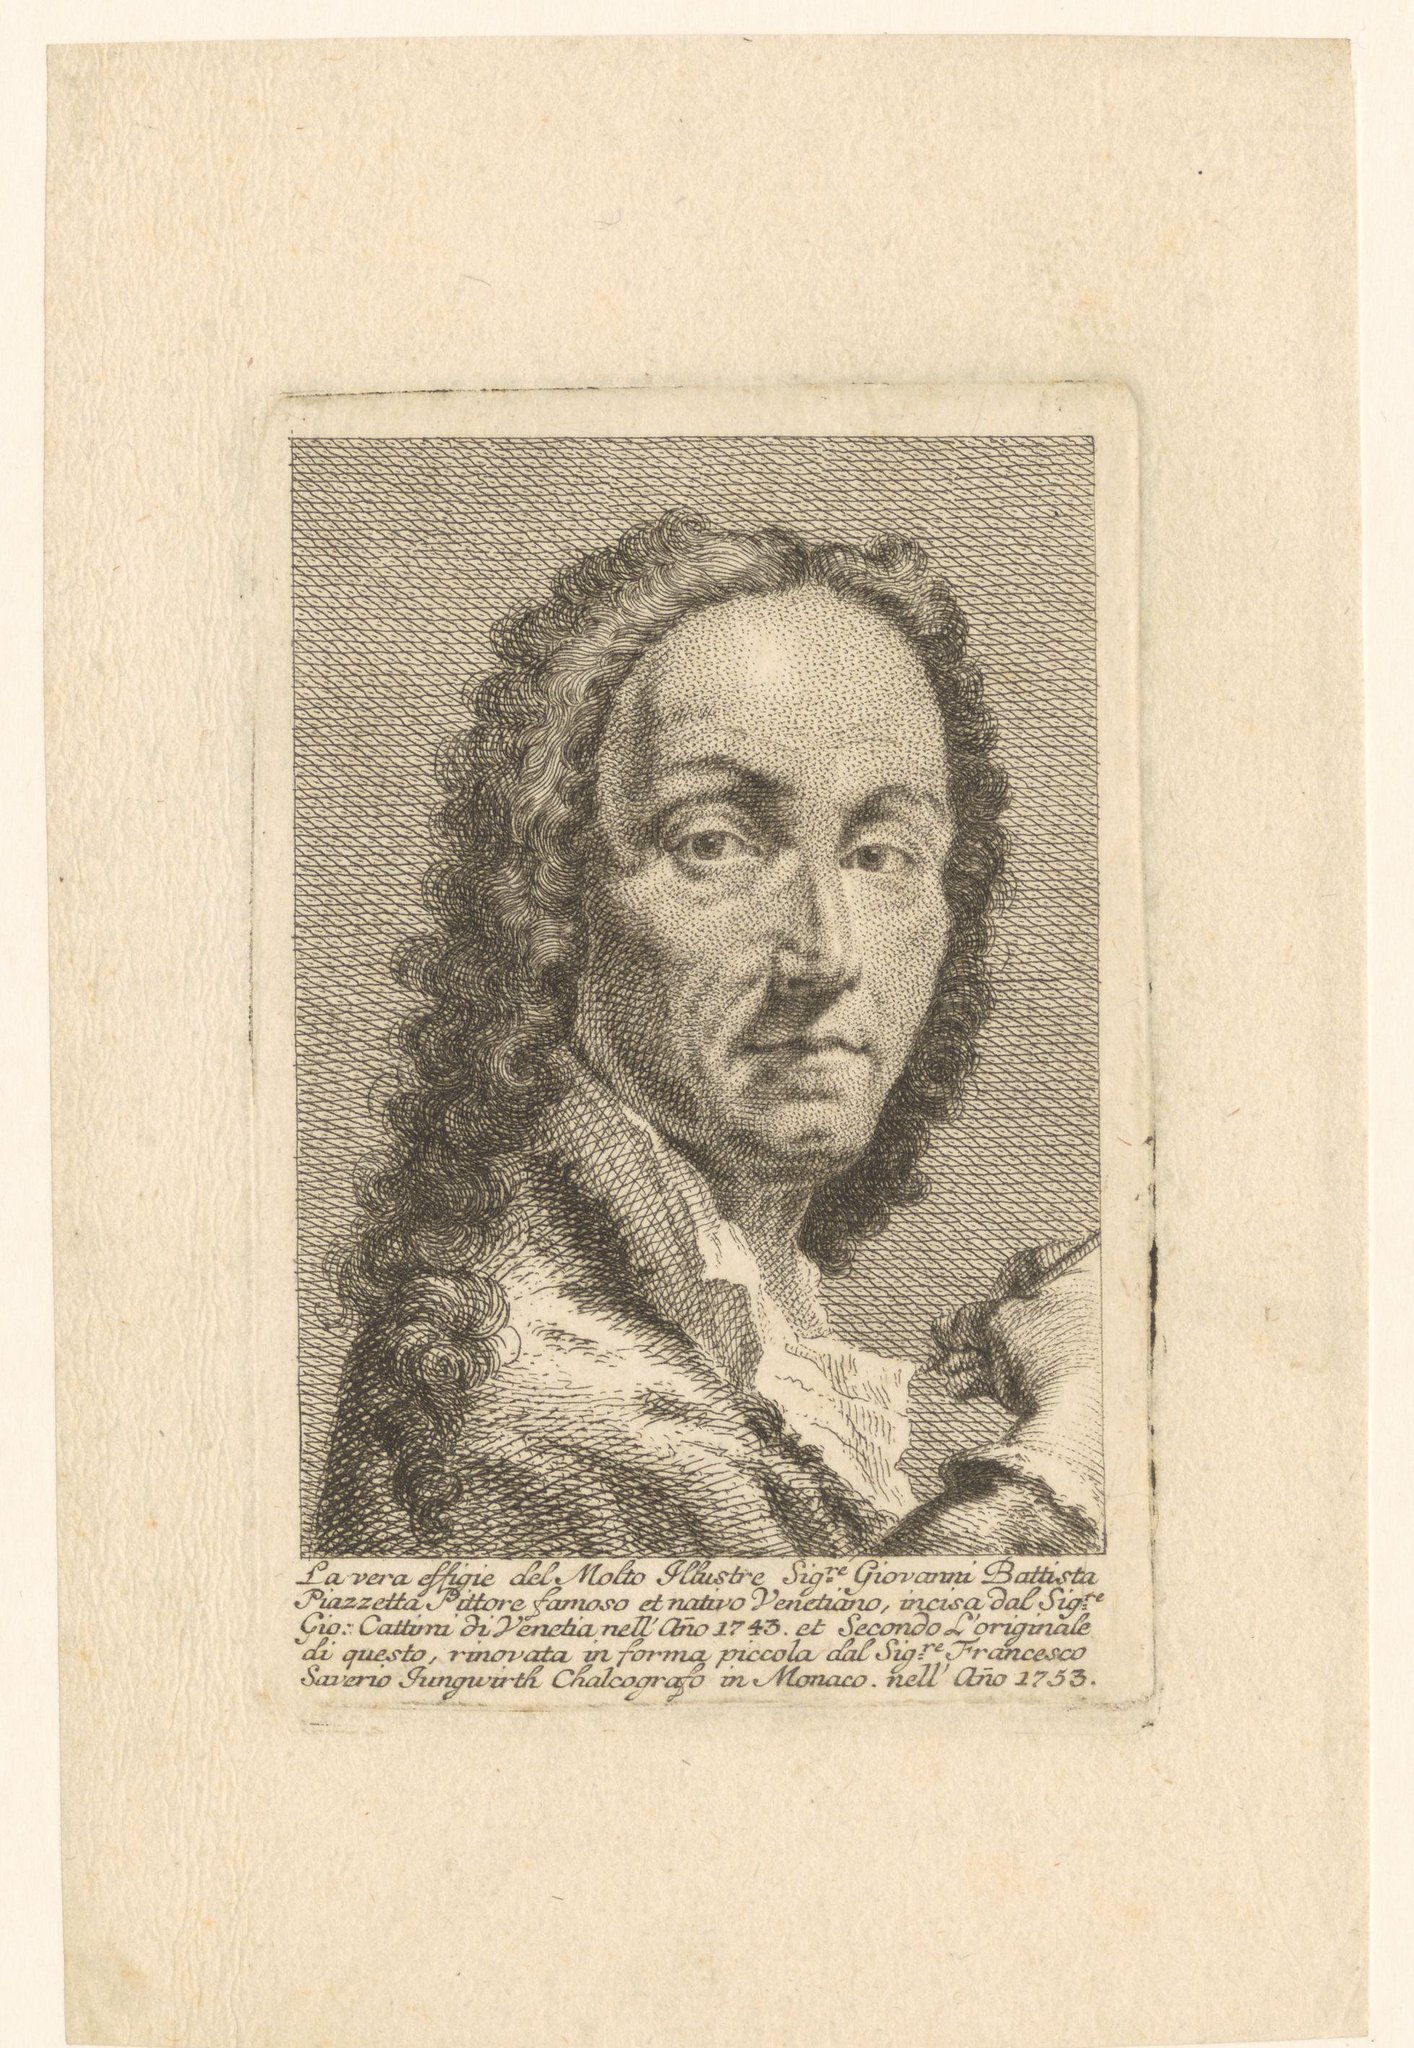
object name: print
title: Portret van Giovanni Battista Piazzetta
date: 1753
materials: paper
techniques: etching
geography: munich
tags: venice, painter, print maker, draughtsman, giovanni battista piazzetta, historical persons, portrait, self-portrait of painter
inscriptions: collector's mark: Lugt 2228